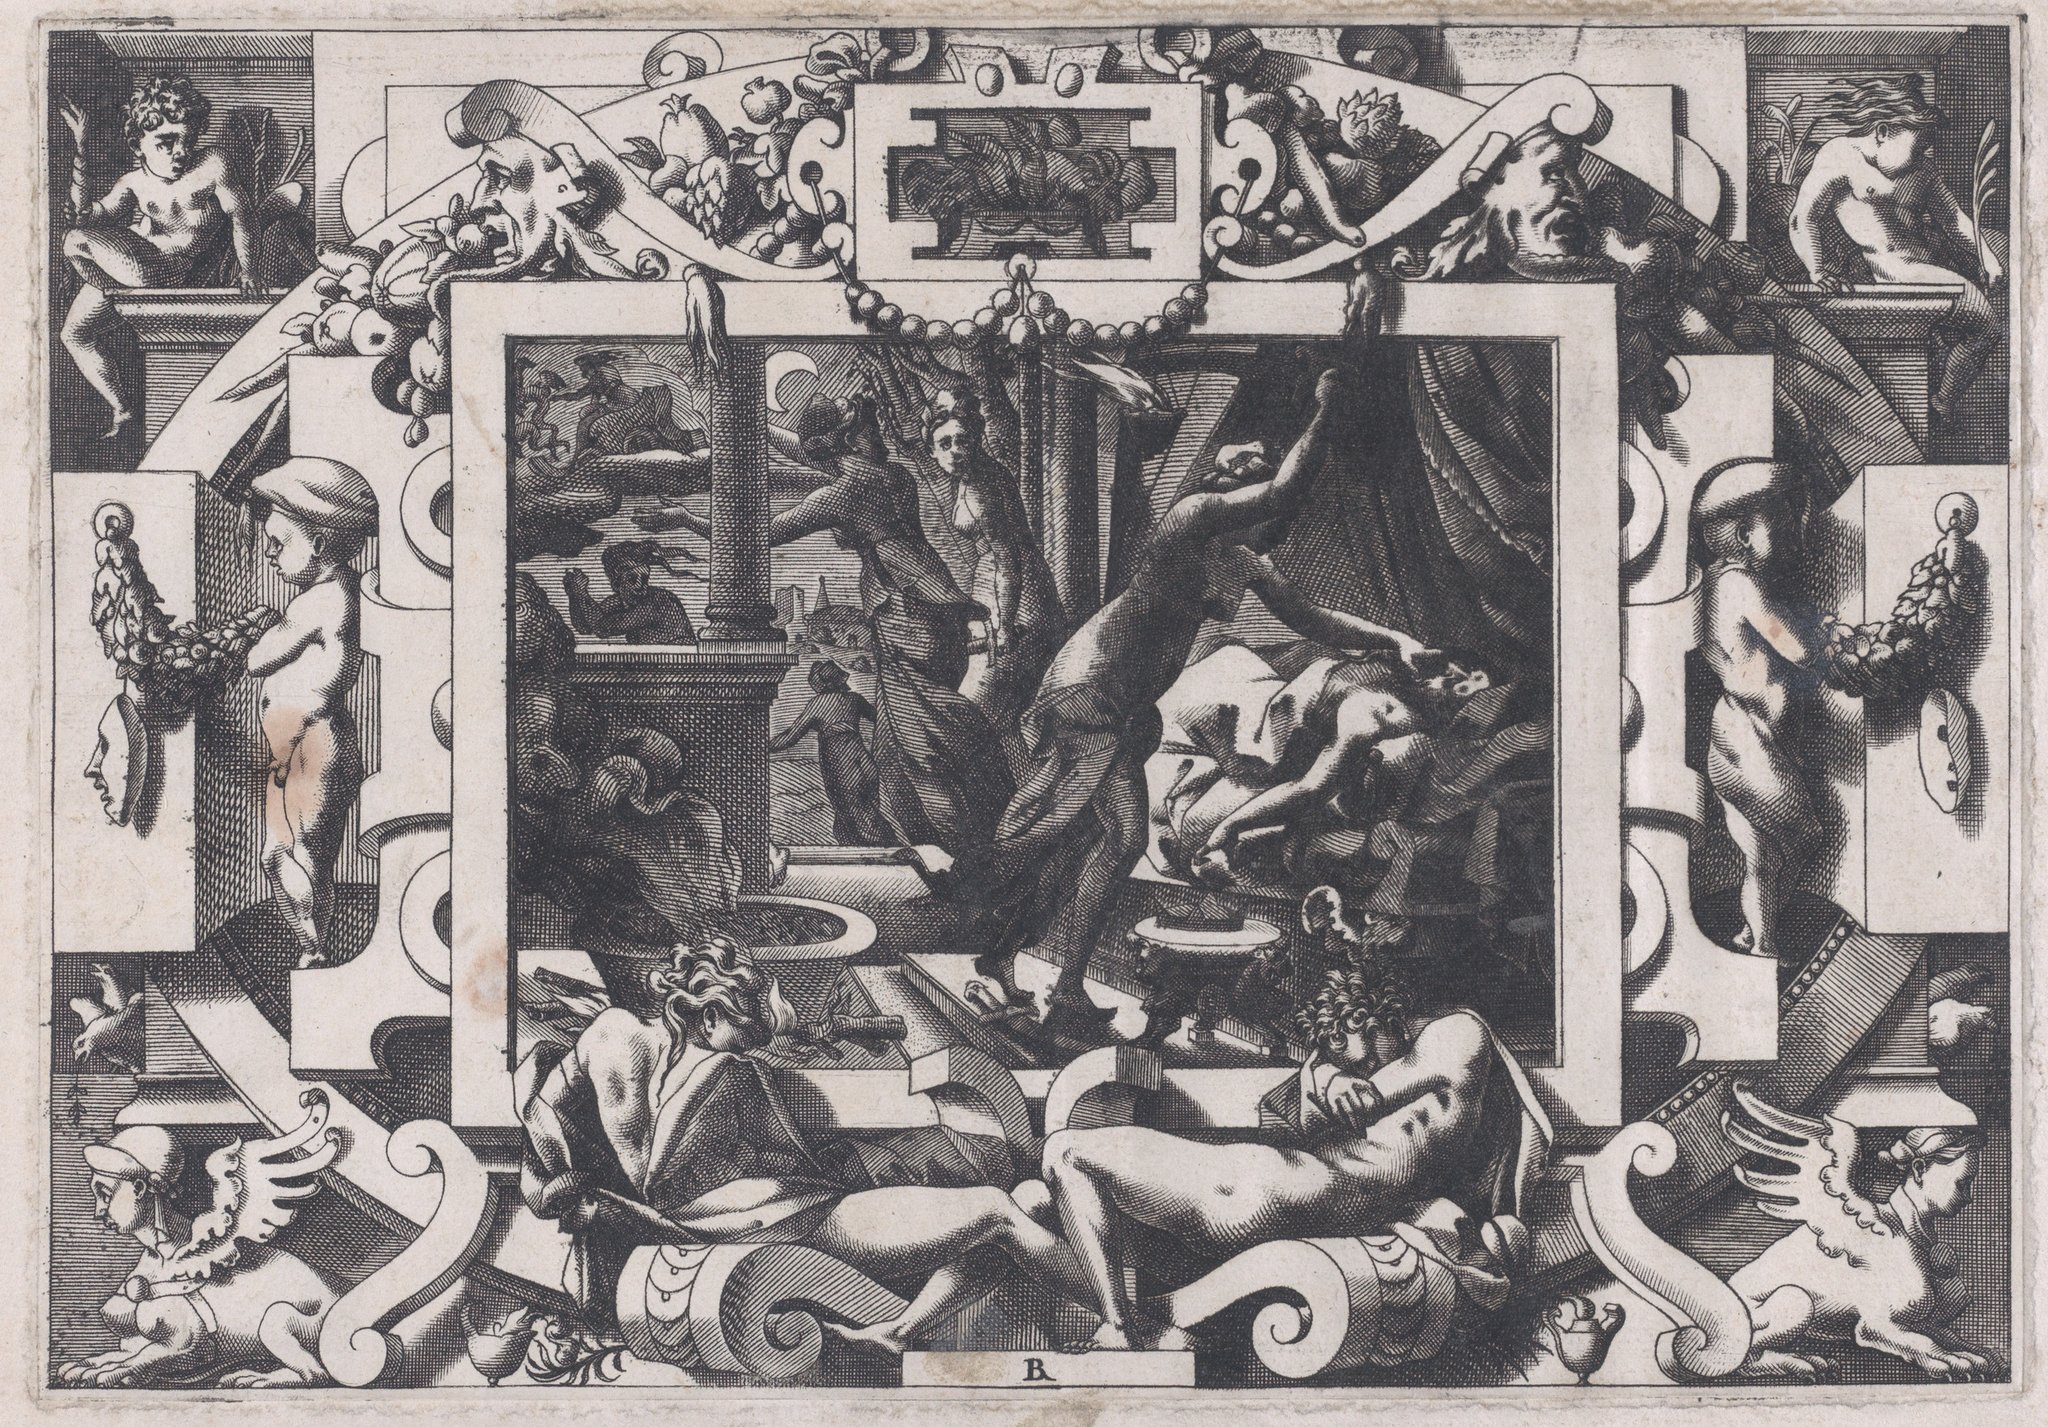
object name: print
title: Pelias Killed by his Daughters (Dont par pitié elles prennent courage son sang vider par violent outrage...), from "Jason and the Golden Fleece"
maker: rené boyvin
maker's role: artist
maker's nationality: french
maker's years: 1525-1598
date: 1563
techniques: engraving